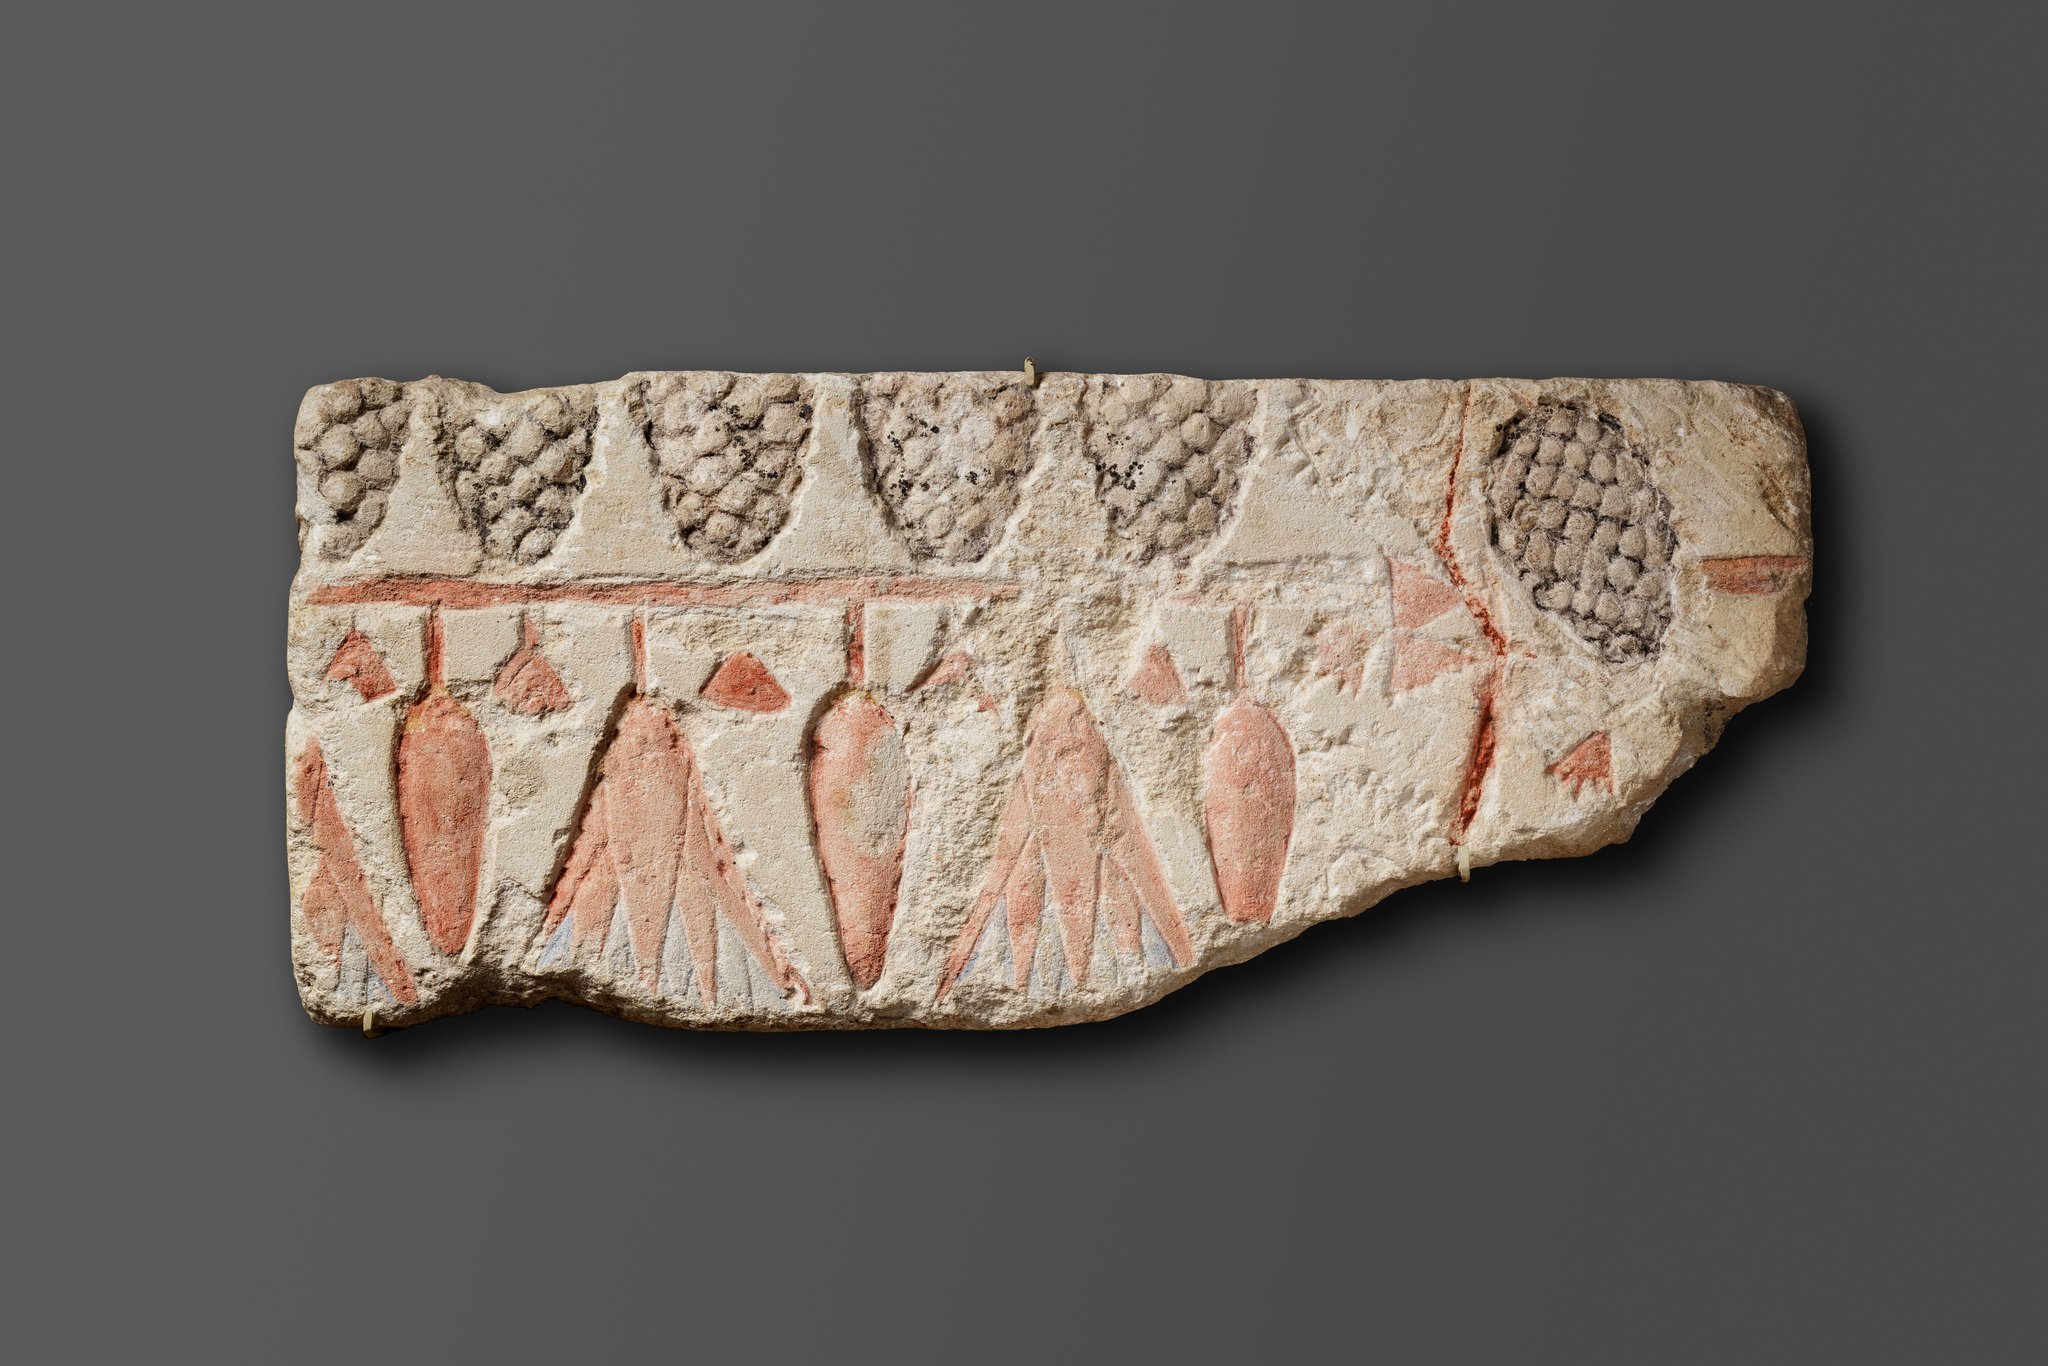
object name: talatat, flower, fruit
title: Relief with floral and fructal wall decoration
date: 1353-1336 BCE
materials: limestone, paint